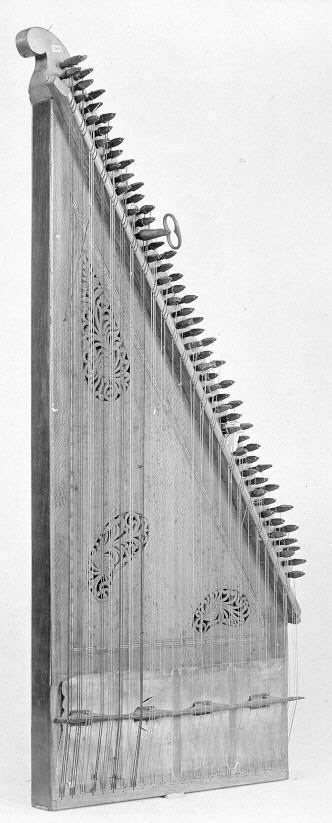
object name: qānūn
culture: turkish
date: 1801-1900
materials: wood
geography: turkey